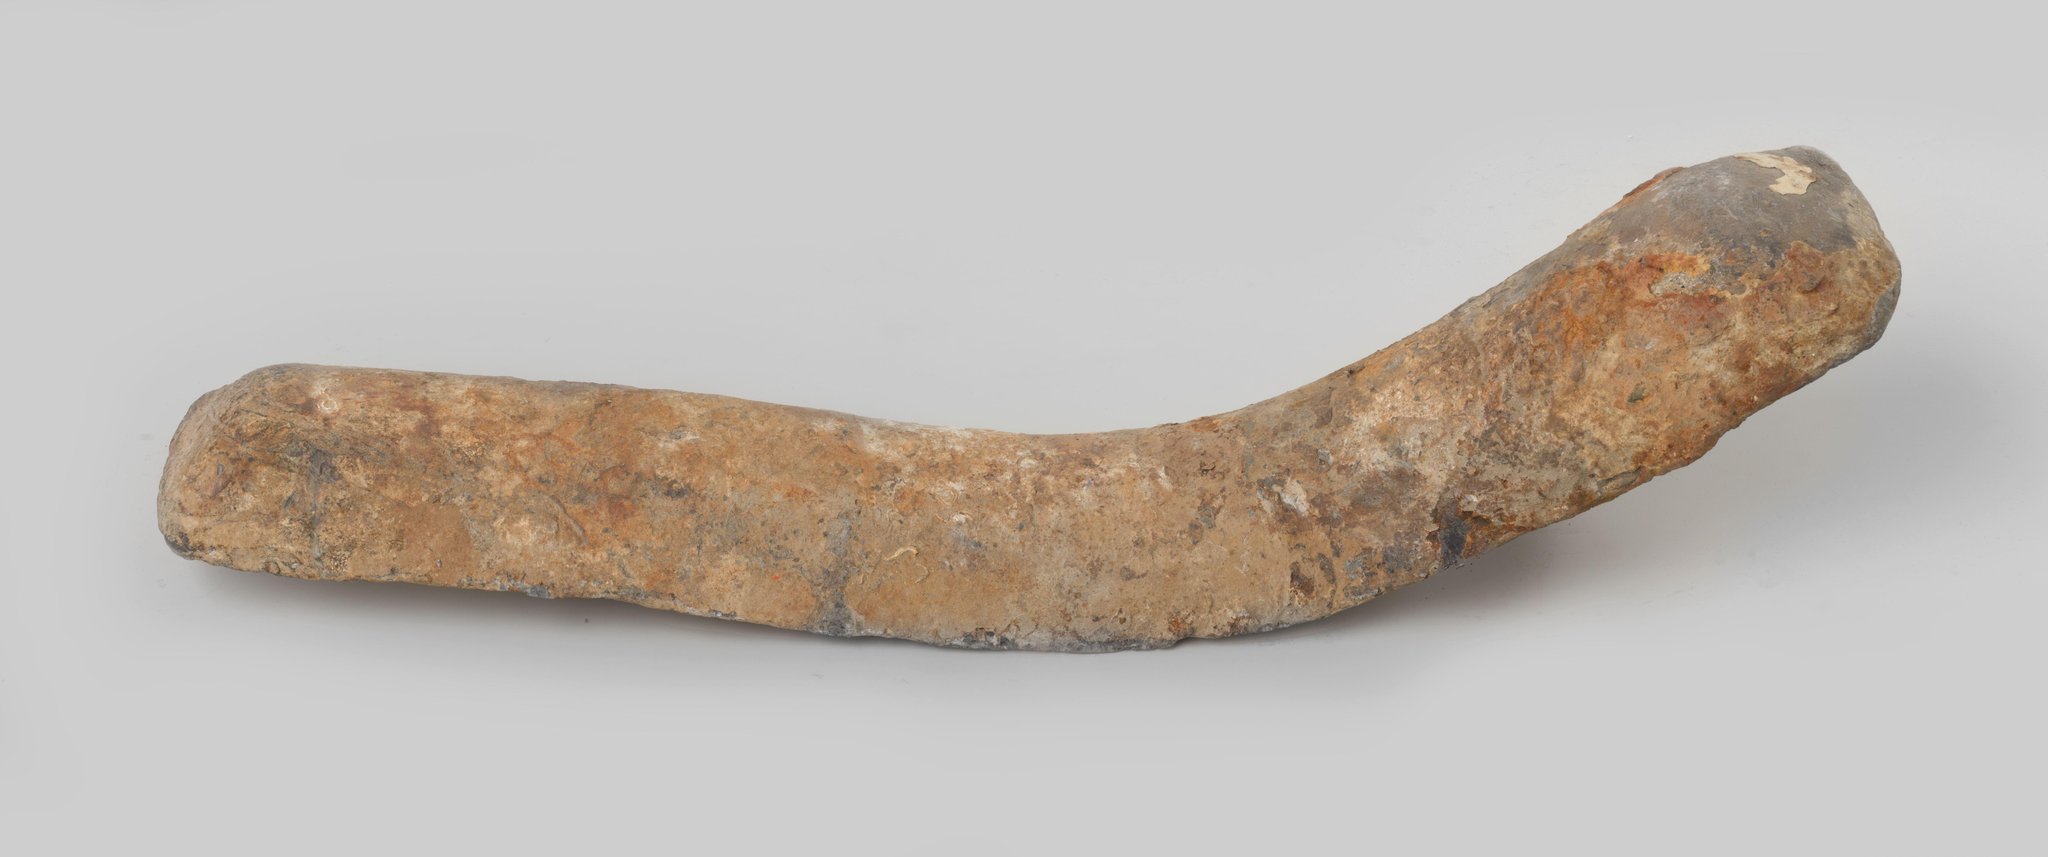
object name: ingot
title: Ballastlood uit het wrak van de Oost-Indiëvaarder Hollandia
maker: Anonymous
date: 1700-1743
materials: lead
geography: netherlands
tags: verenigde oostindische compagnie, hollandia (schip), annet